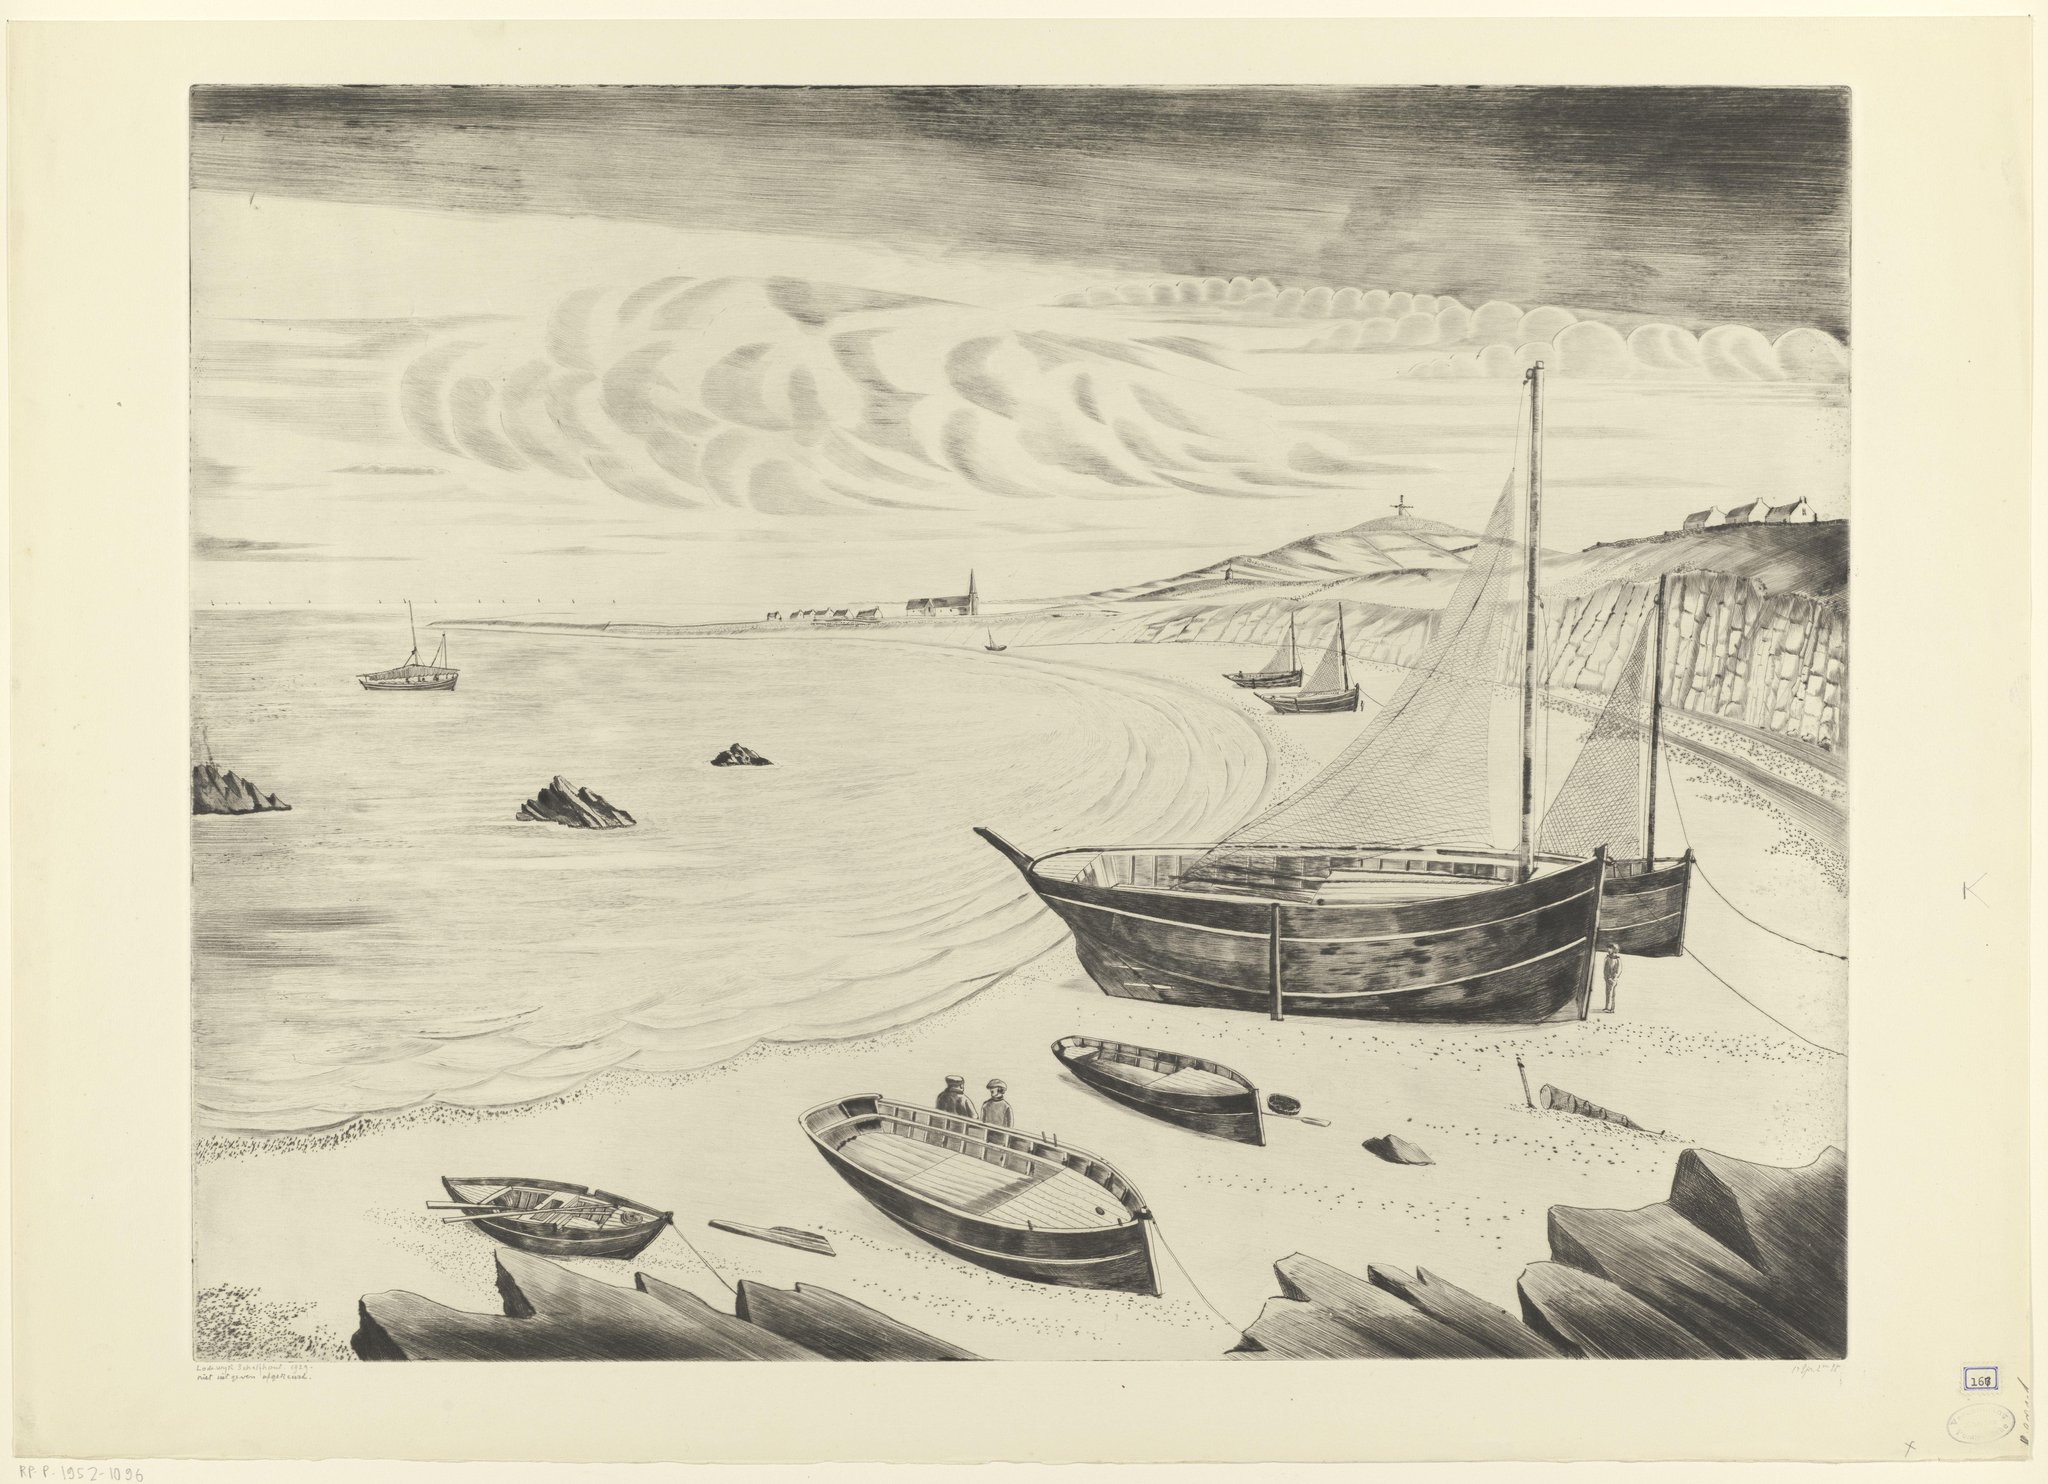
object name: print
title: Acht afgemeerde schepen op een strand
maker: lodewijk schelfhout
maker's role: draughtsman, print maker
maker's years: 1881-1943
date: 1929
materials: paper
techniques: drypoint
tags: ships (in general), beach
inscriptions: inscription: ‘niet uitgegeven. afgekeurd.’, collector's mark: Lugt 2228, collector's mark: Lugt 5i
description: Op de voorgrond rotsen. Rechts een strook land met huizen, een kerk en een molen.